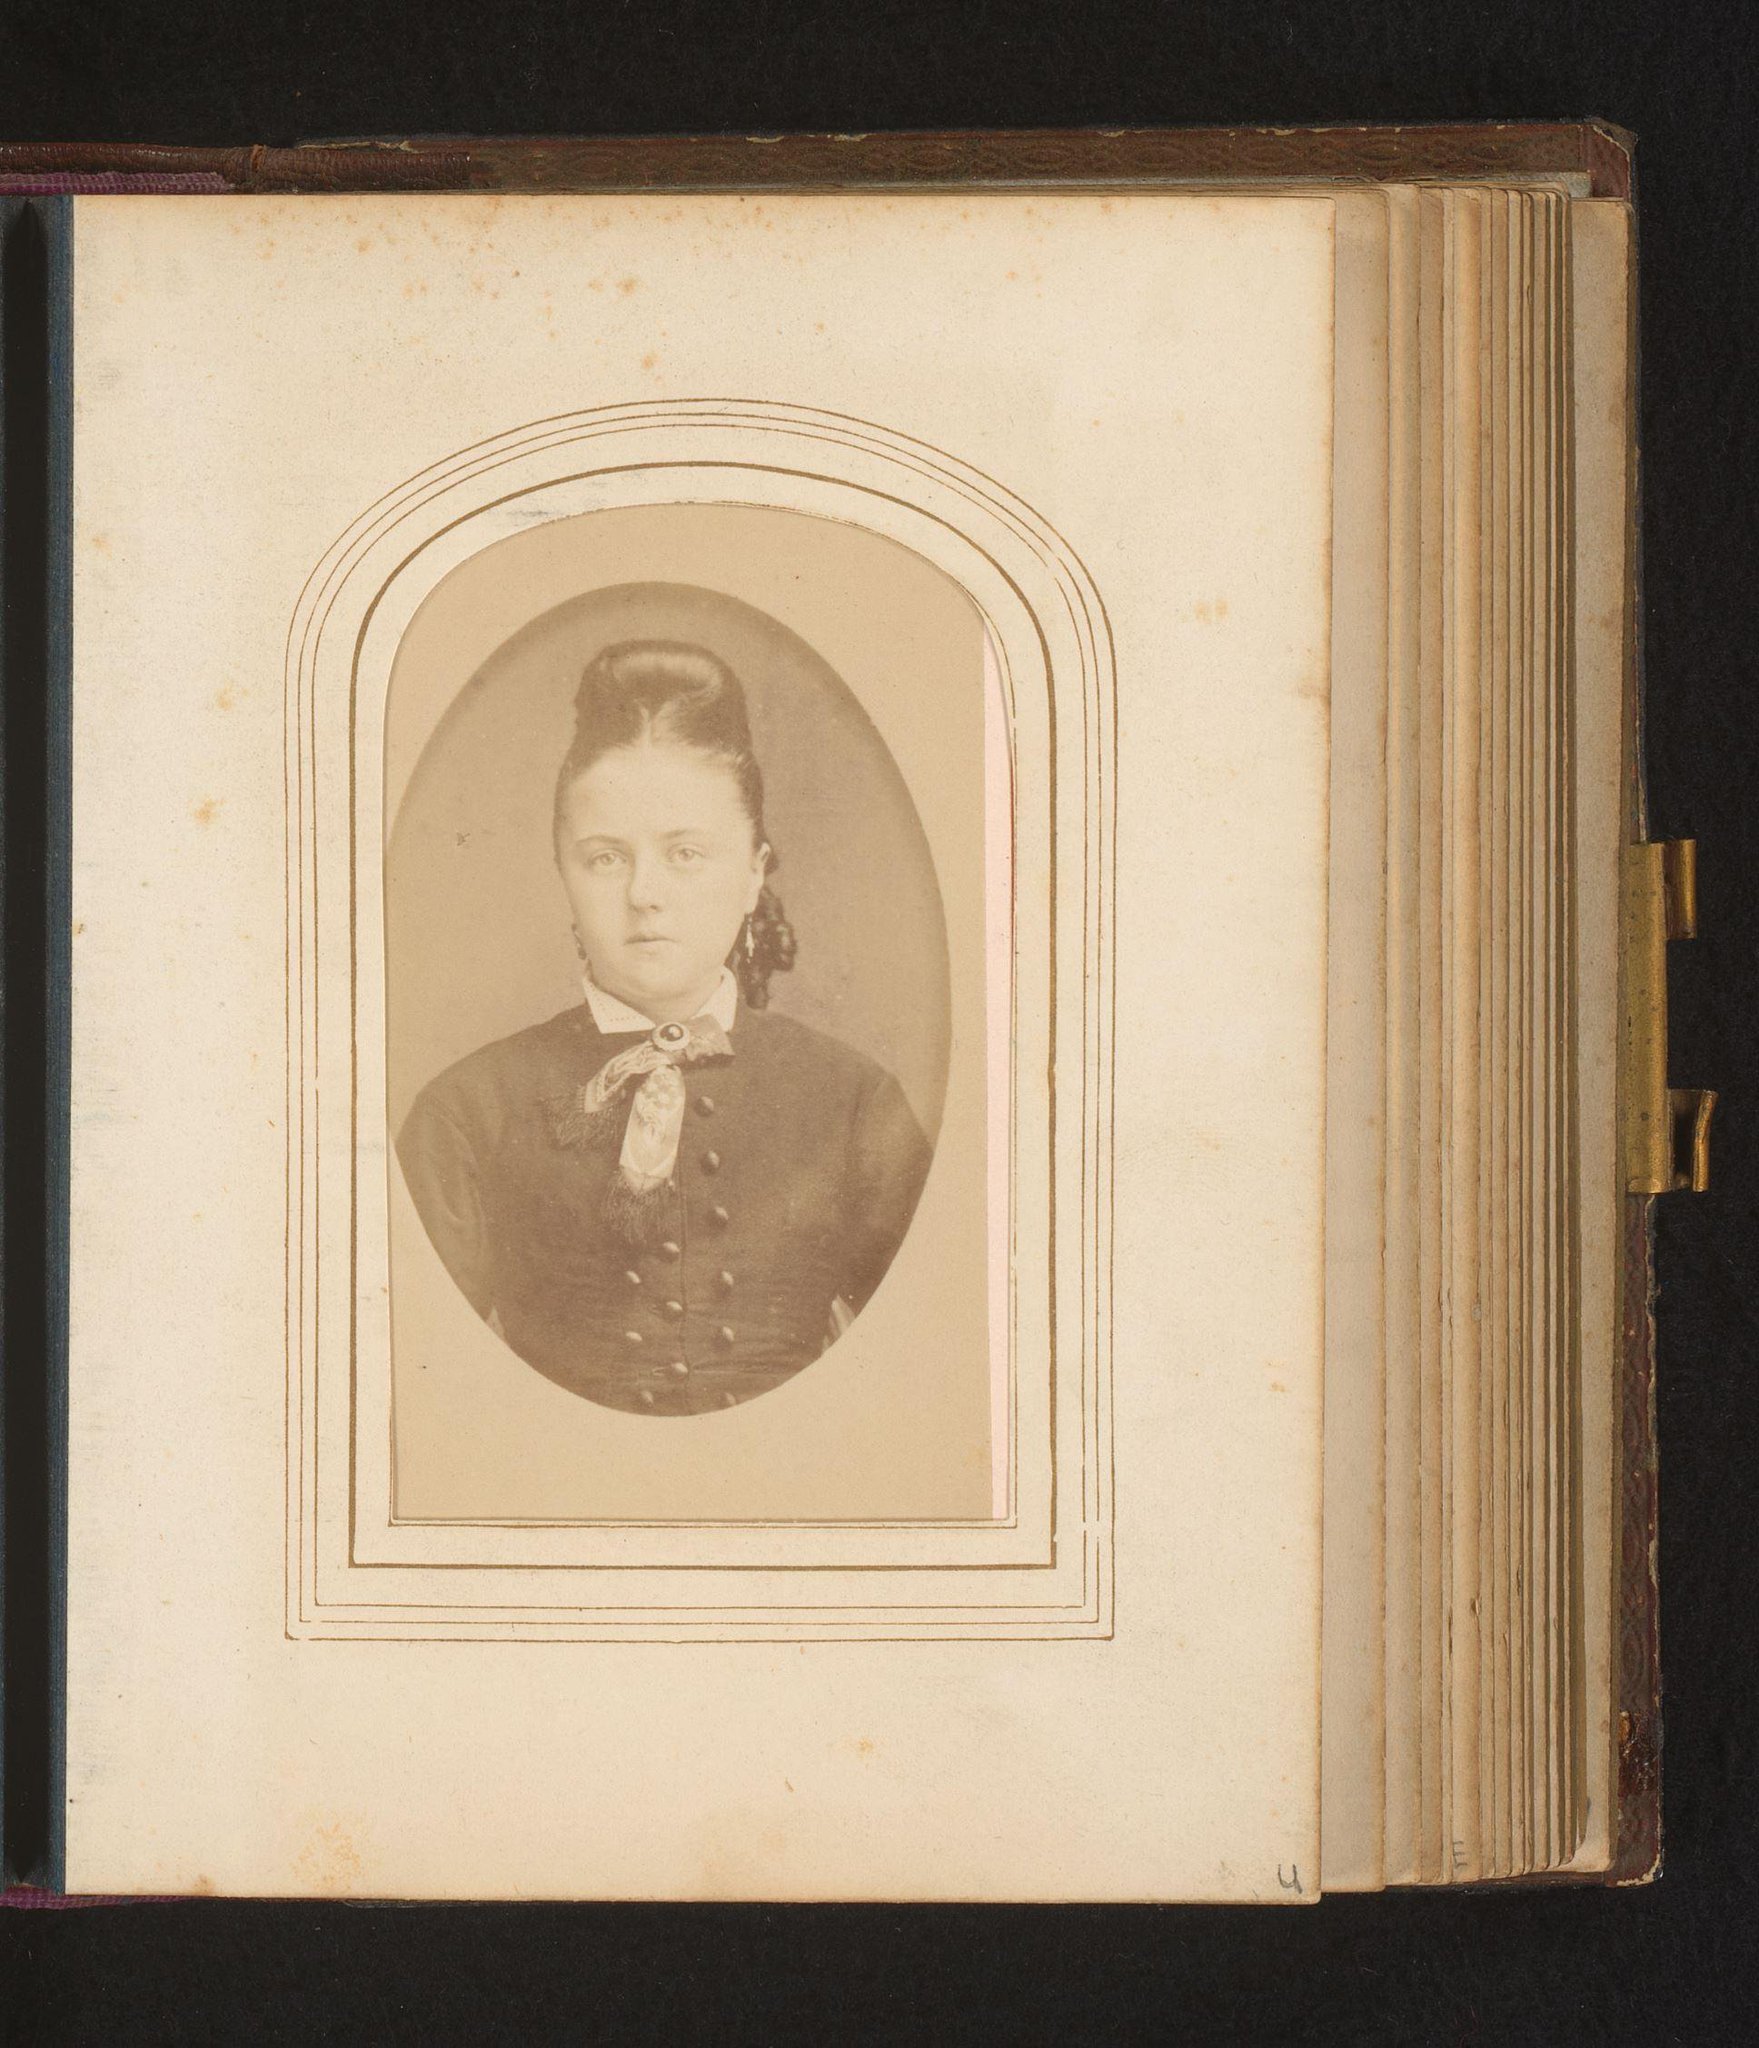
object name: carte de visite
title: Portret van een meisje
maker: godfried de jong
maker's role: print maker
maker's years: 1832-1918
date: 1874-1887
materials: cardboard, photographic support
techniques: albumen print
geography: groningen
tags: historical persons - bb - woman, girl (child between toddler and youth)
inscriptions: inscription: ‘Godfried de Jong/ Photographe-Artiste/ van Z.M. den Koning./ Bekroond/ op de Internationale Tentoonstelling/ te AMSTERDAM 1874./ Academie-Medaille/ in de teekenkunst/ Groningen/ Heerestraat./ Van deze photographie kan nabesteld worden./ Vergrooting naar visite kaarten in alle afmetingen.’